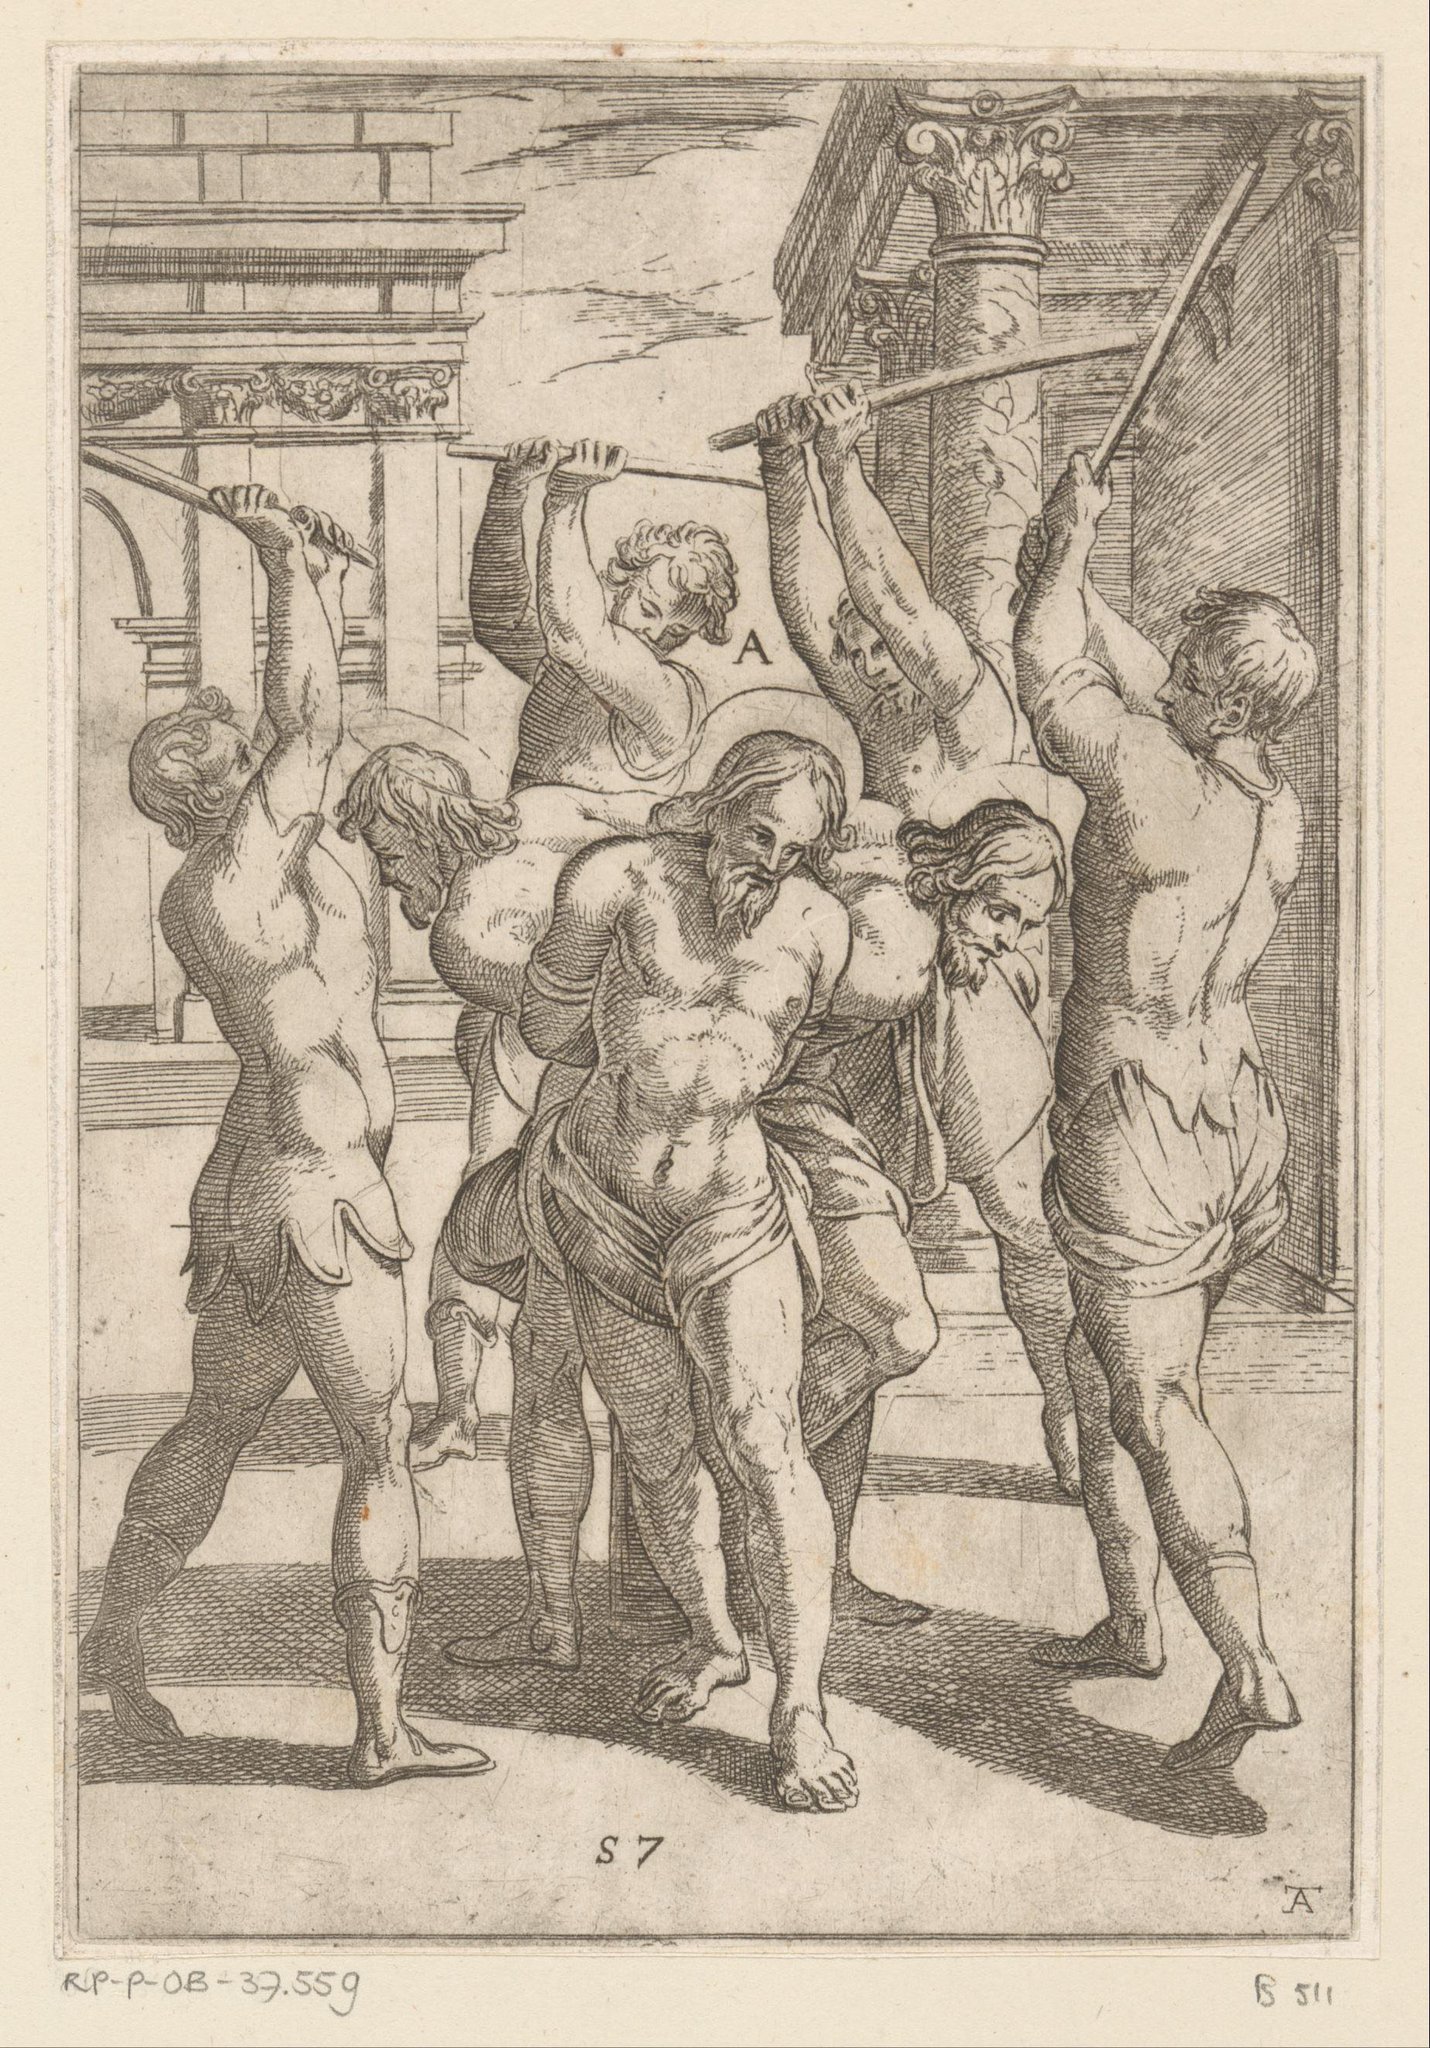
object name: print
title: Martelingen ondergaan door christelijke martelaars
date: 1565-1630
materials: paper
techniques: etching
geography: vatican city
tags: violent death ~ maltreatment, torture, torture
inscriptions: collector's mark: Lugt 240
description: Deze prent maakt deel uit van een reeks van 47 prenten (+ titelprent) met voorstellingen van martelmethoden. Deze prenten zijn in een andere editie gebruikt als illustraties voor Antonio Gallonio's 'Trattato degli Instrumenti di Martirio e delle Varie Maniere di Martoriare Usate dai Gentili contro Christiani' (Rome, Ascanio en Girolamo Dongangeli, 1591).